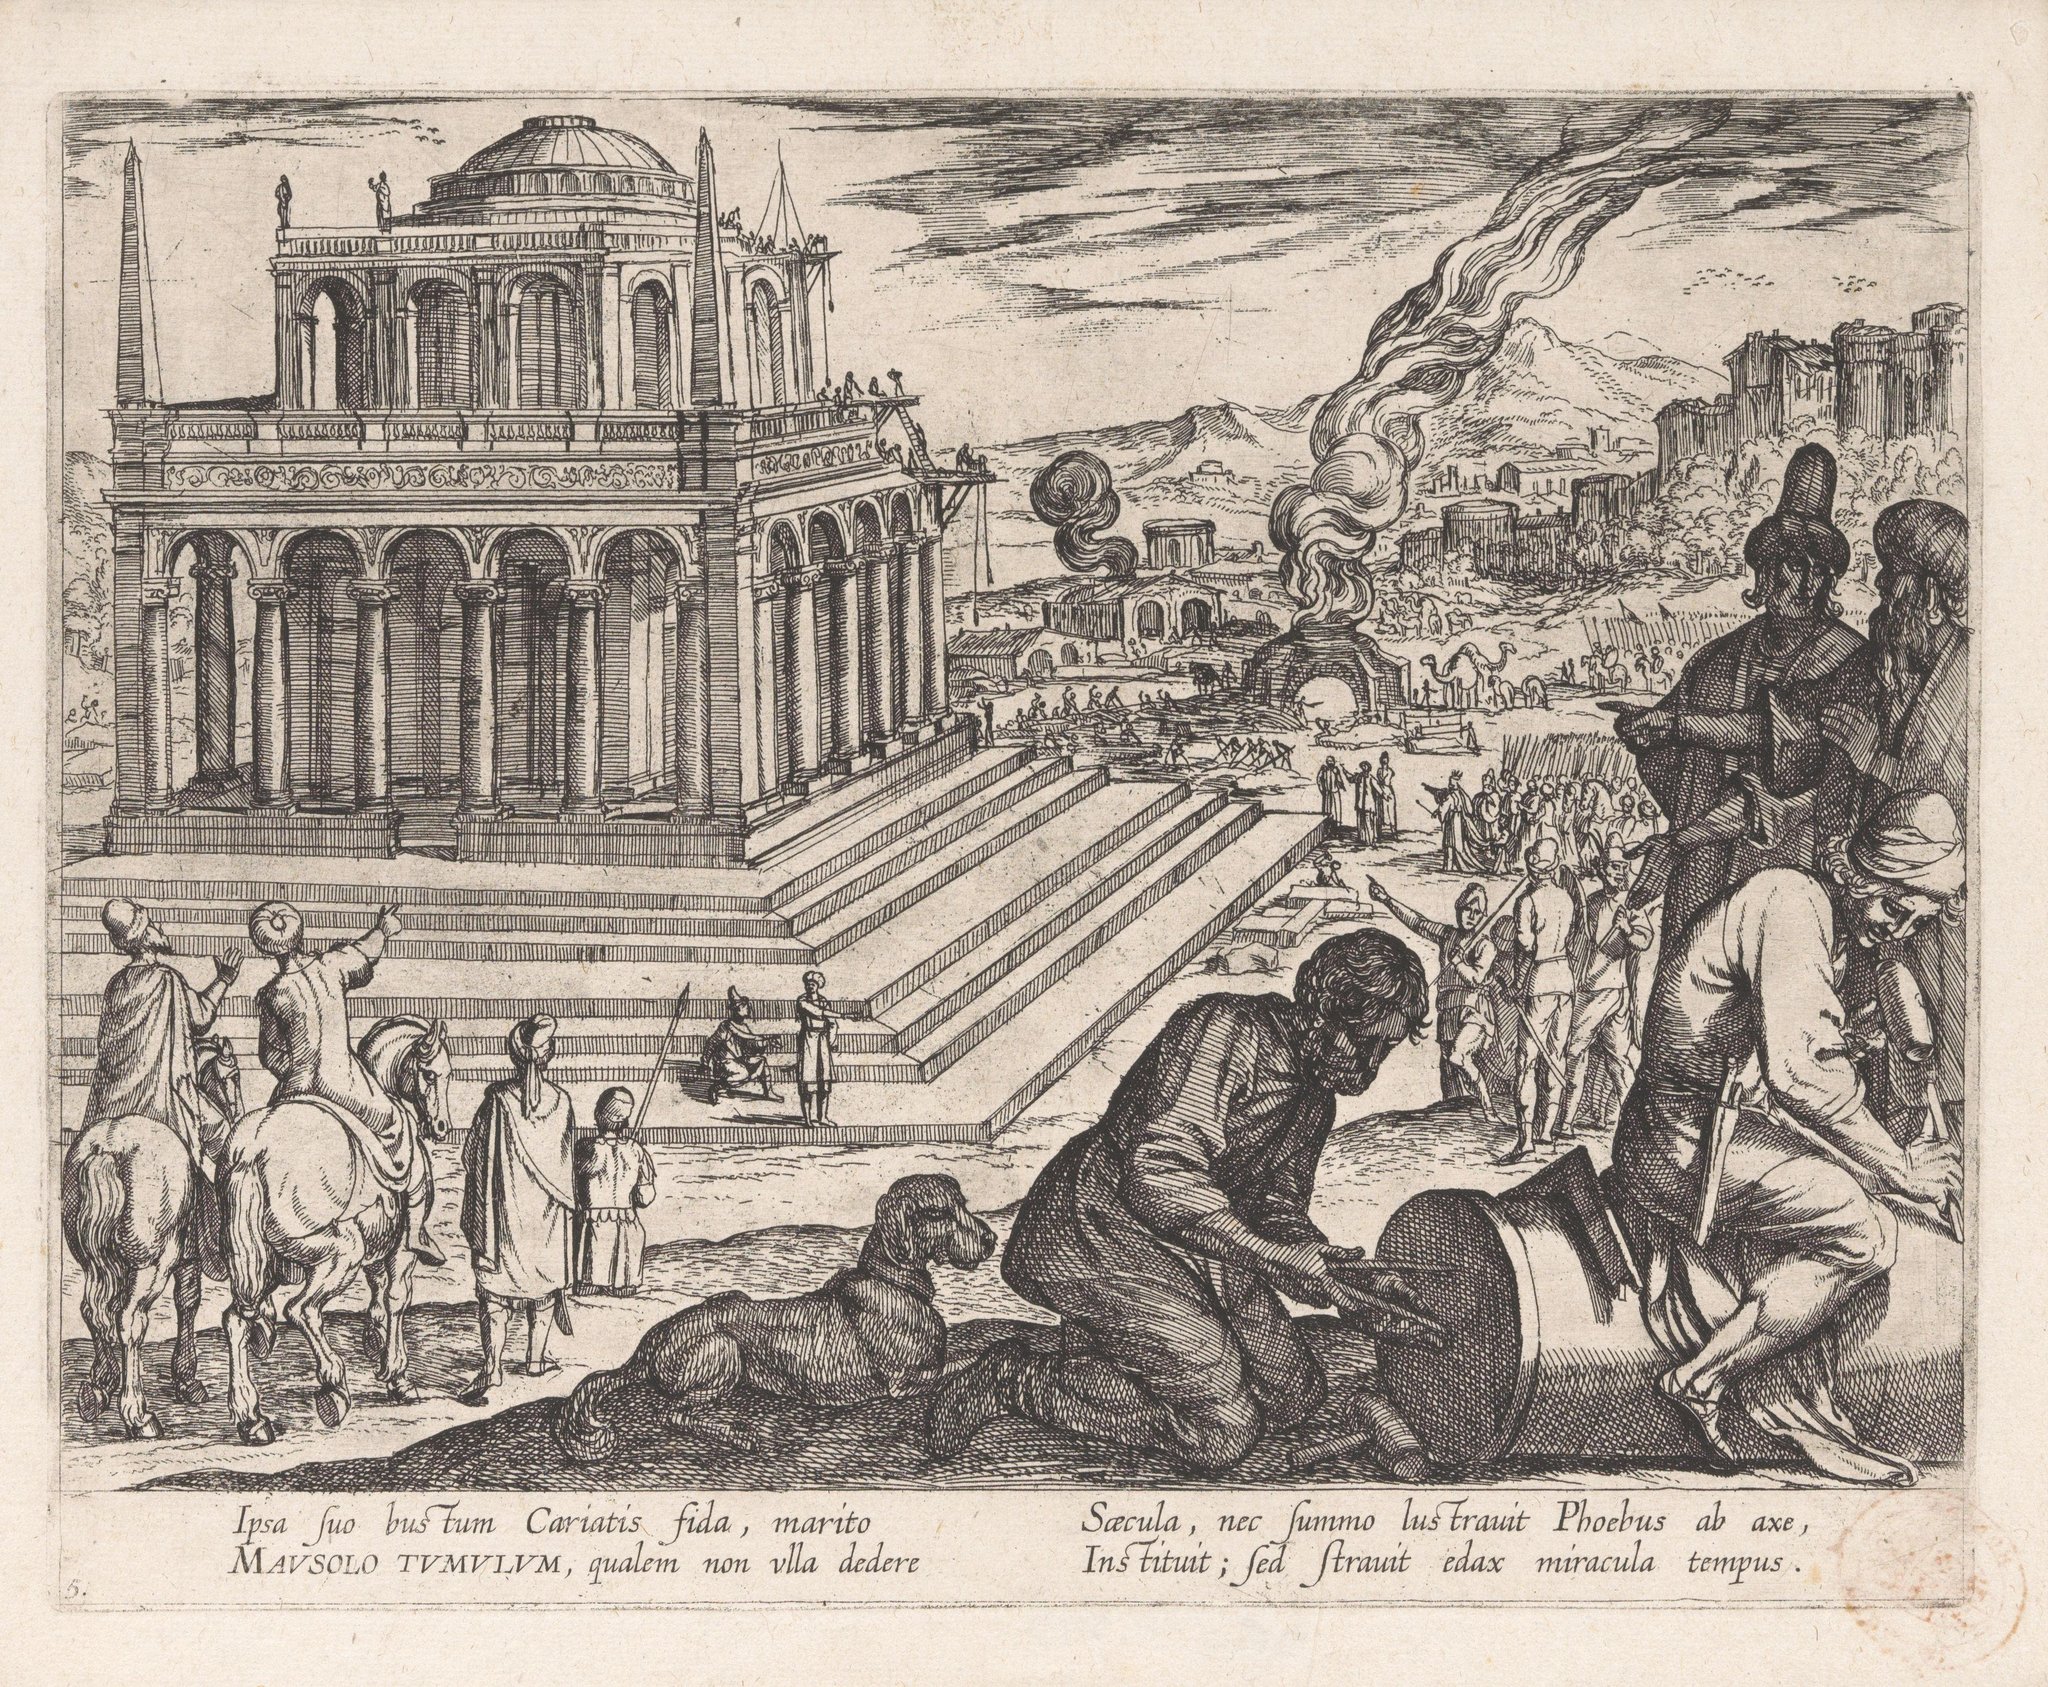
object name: print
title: De zeven wereldwonderen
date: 1608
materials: paper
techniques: etching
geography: antwerp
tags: the seven wonders of the world, mausoleum at halicarnassus (wonder of the world)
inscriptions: collector's mark: Lugt 240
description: Het Mausoleum van Halicarnassus in aanbouw. De graftombe van koning Mausolus, een Perzische stadsvorst van Halicarnassus uit de 4e eeuw v. Chr. Het werd na zijn dood in 353 v. Chr. gebouwd in opdracht van zijn weduwe, koningin Artemisa. Tekst in het Latijn in ondermarge.